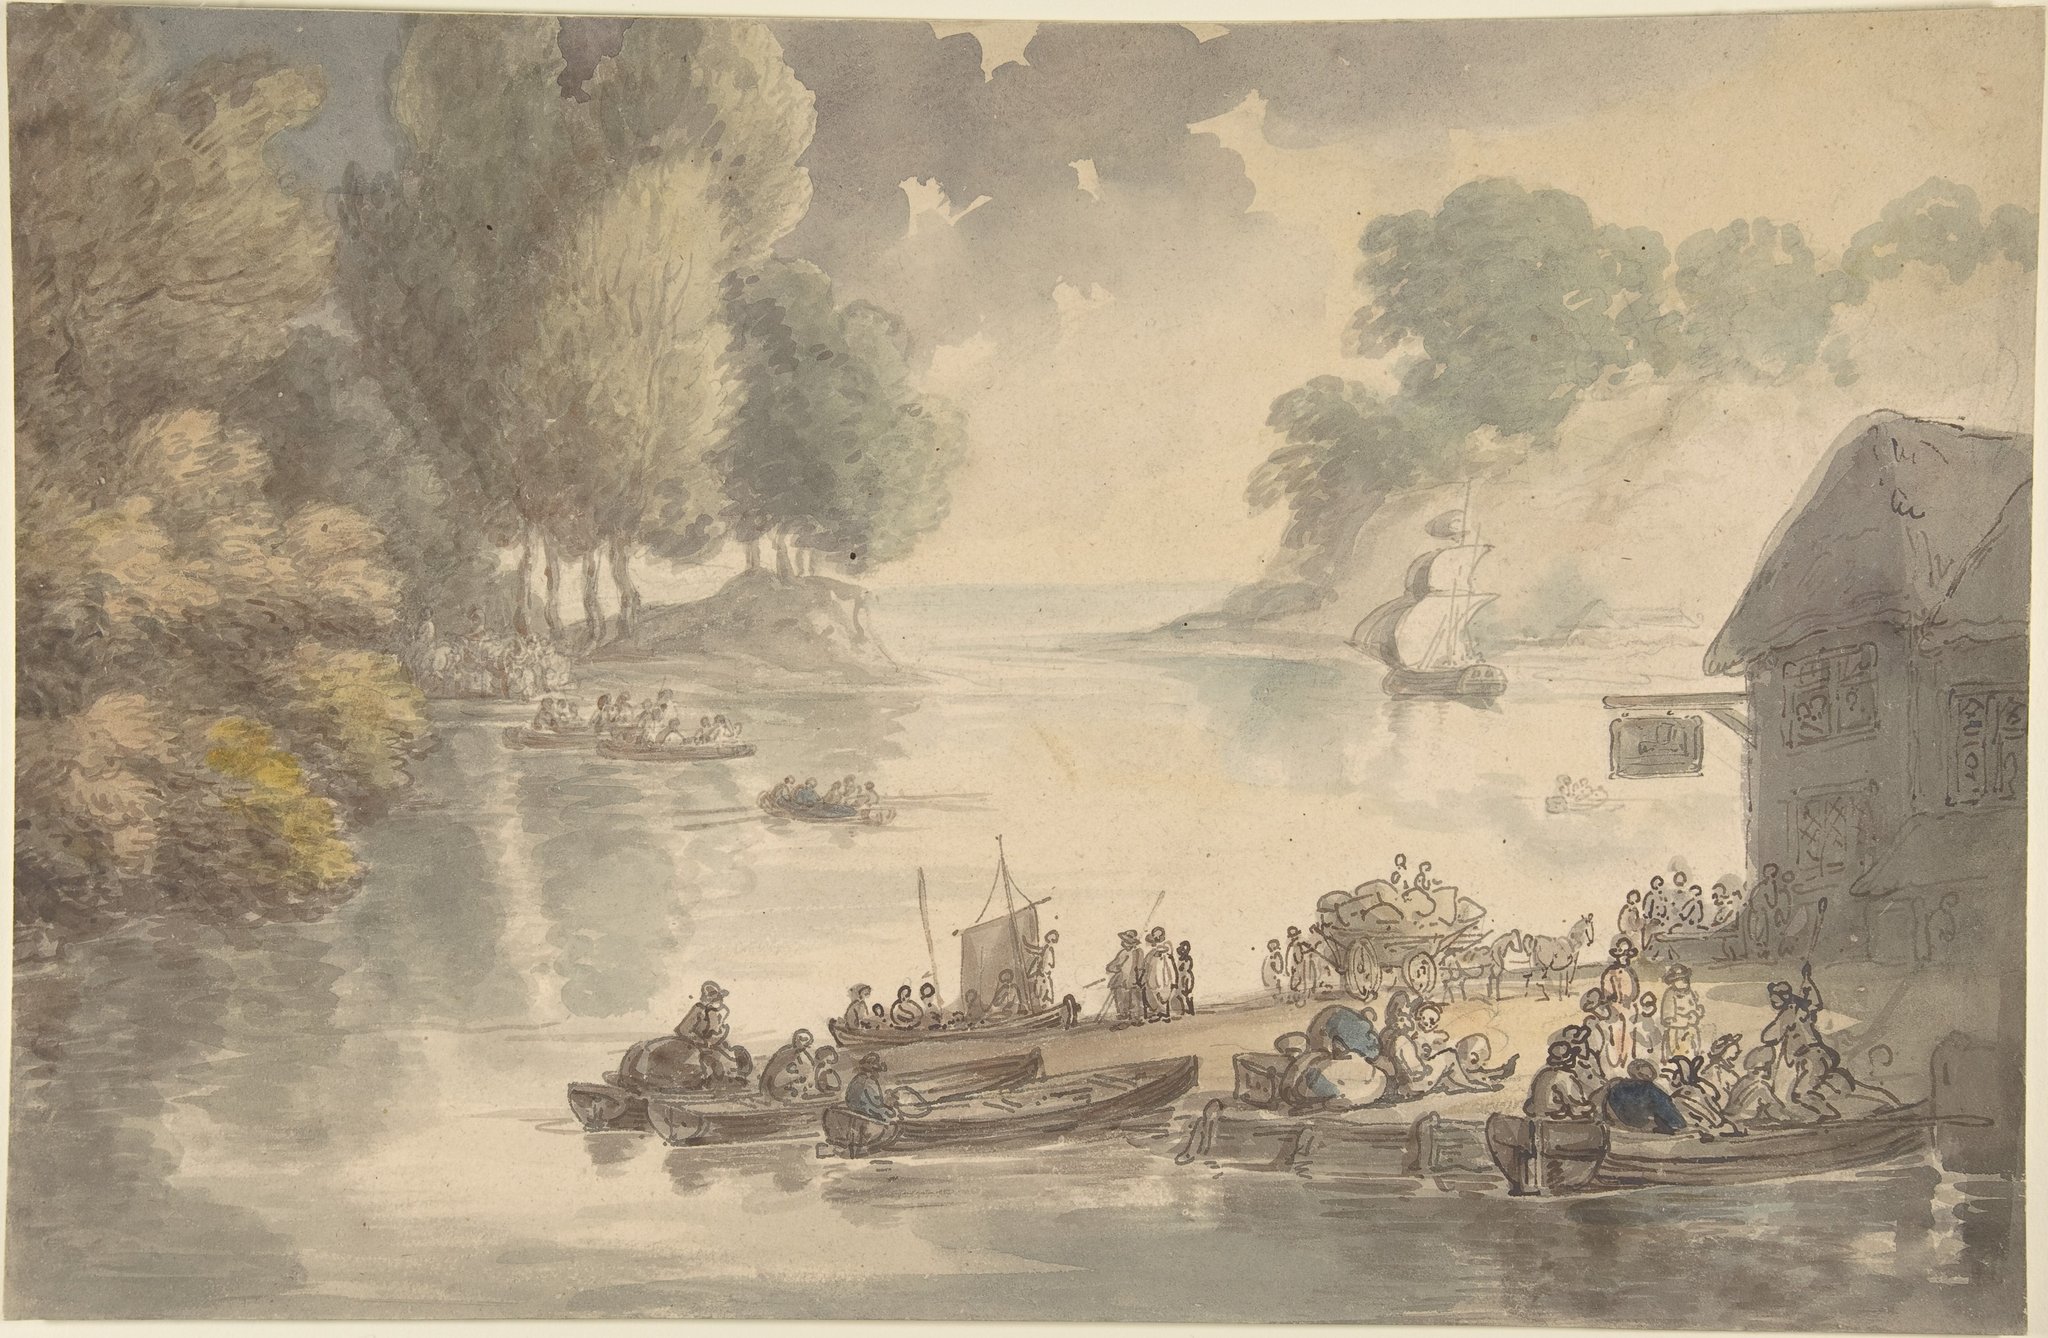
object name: drawing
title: The Inn at the Ford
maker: thomas rowlandson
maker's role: artist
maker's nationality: british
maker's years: 1757-1827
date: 1775-1827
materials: watercolor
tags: inns,rivers,landscapes,boats